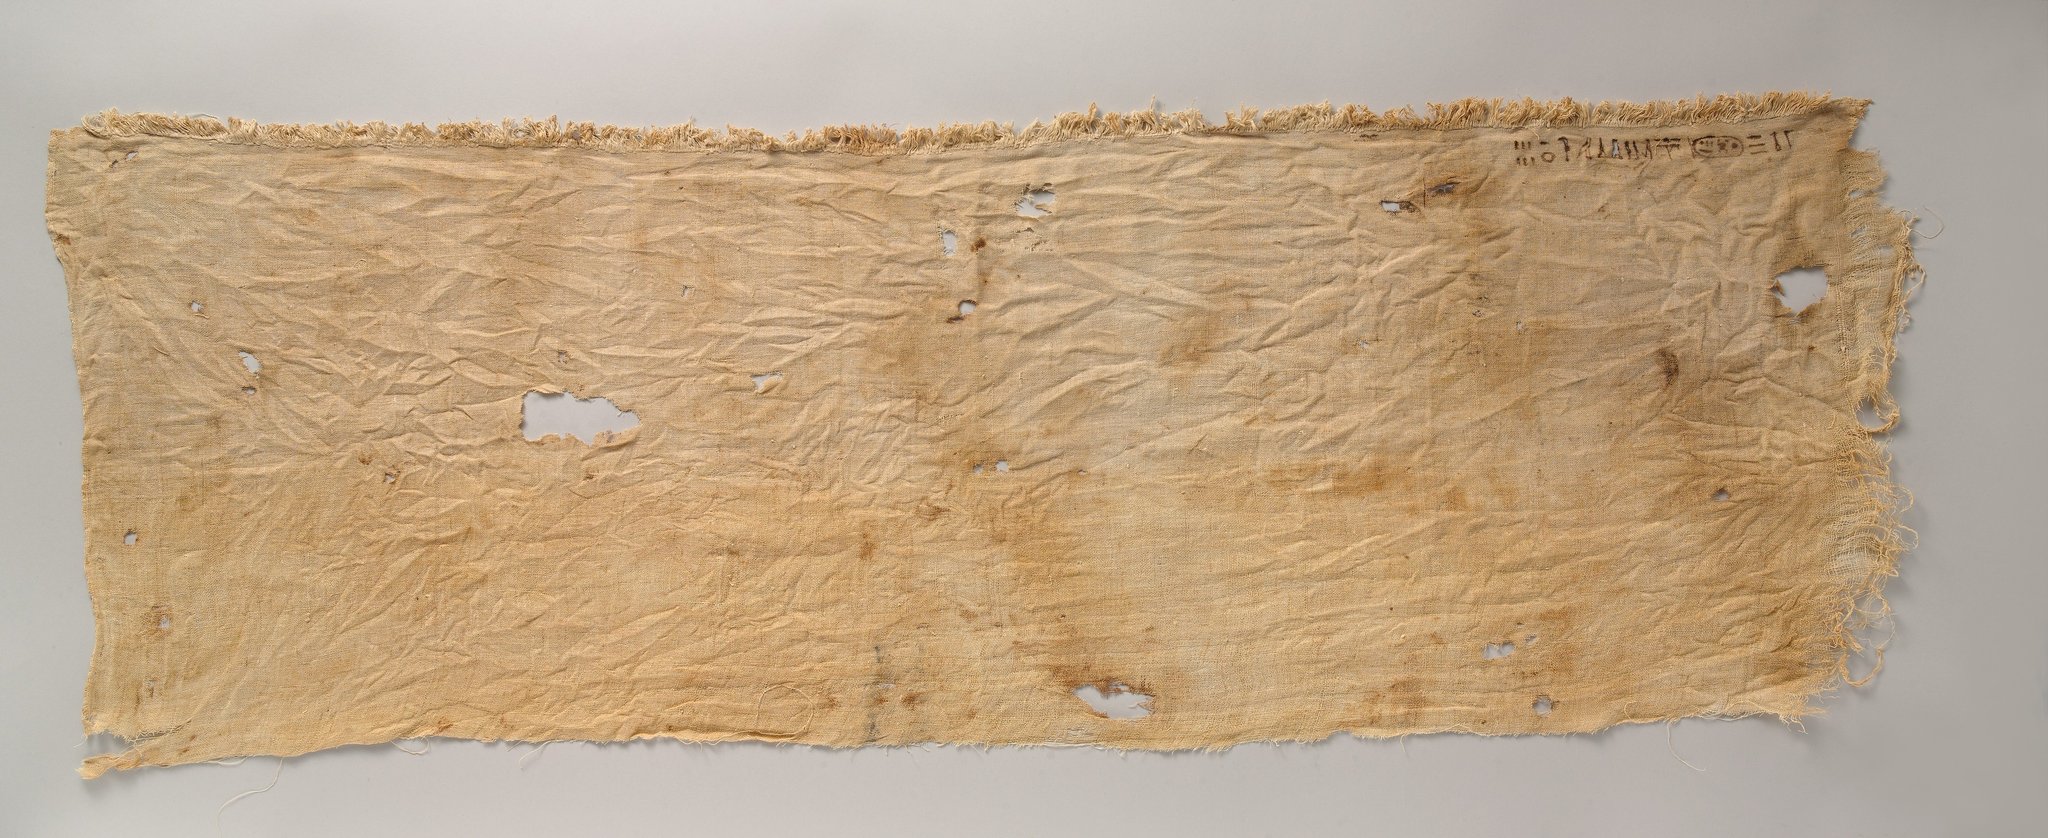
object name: linen, tutankhamun cache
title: Linen from Tutankhamun's Embalming Cache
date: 1336-1327 BCE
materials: ink, linen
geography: egypt